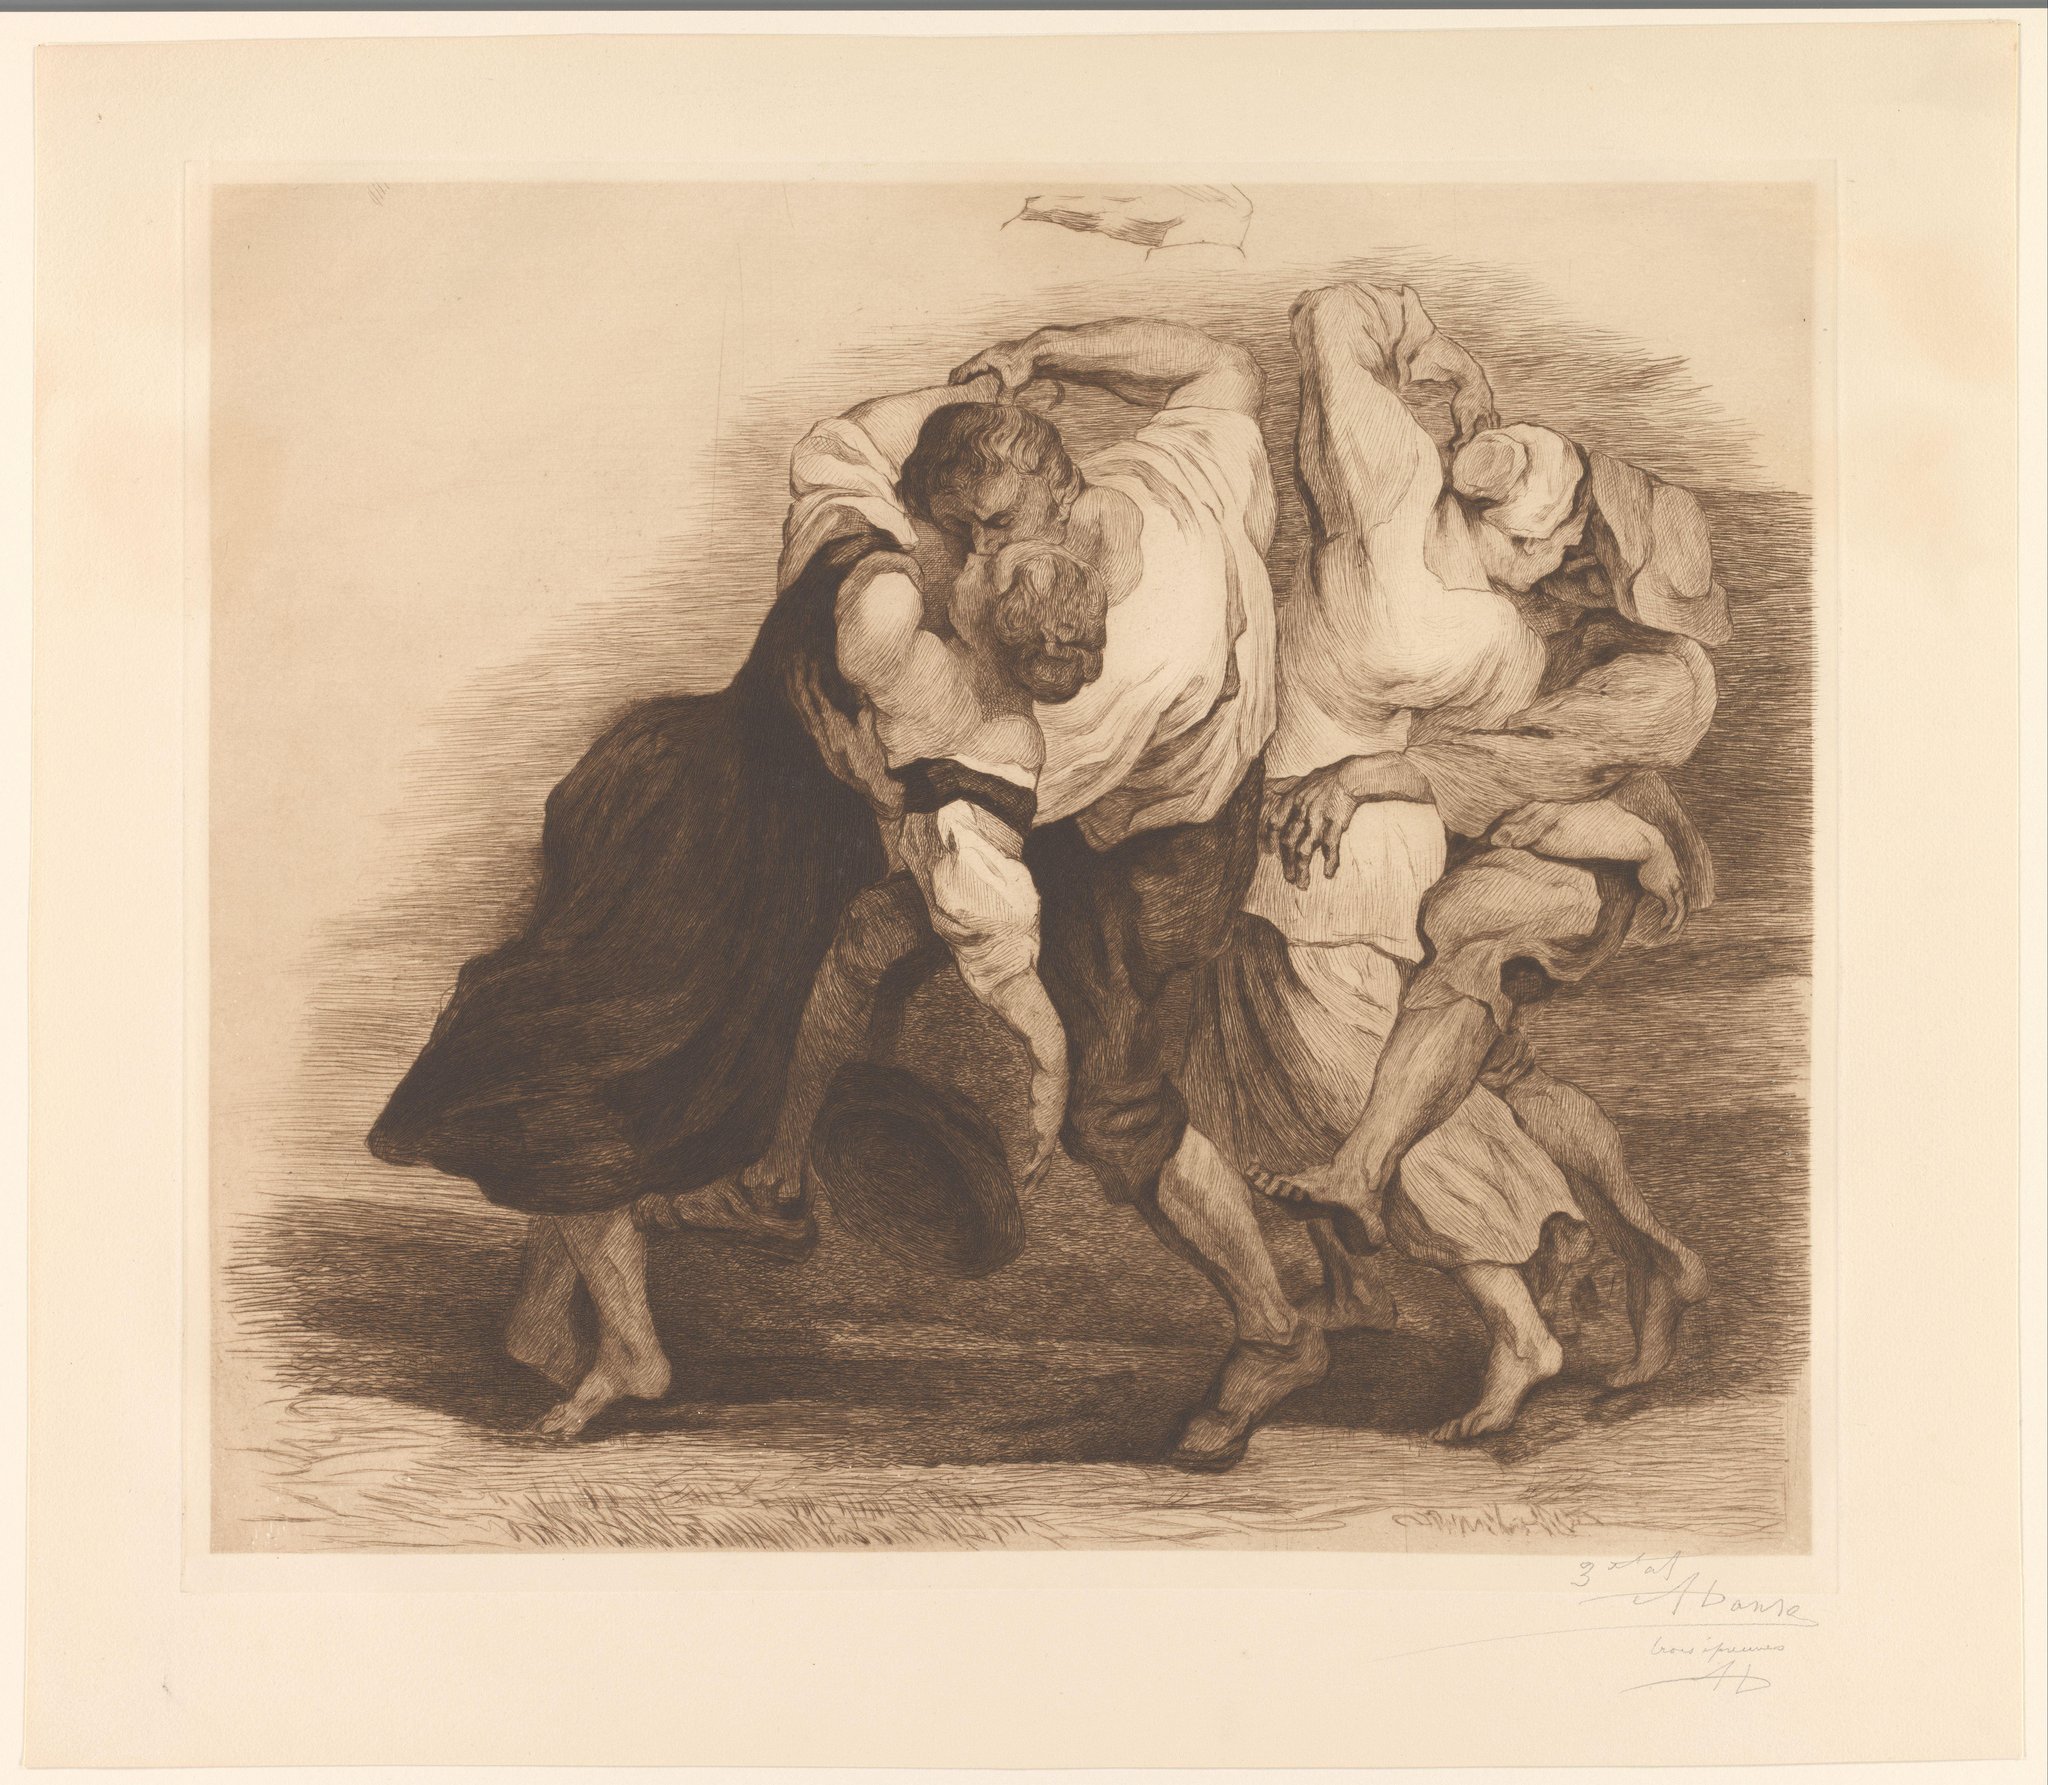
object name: print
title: Twee dansende boerenparen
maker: auguste danse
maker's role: print maker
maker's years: 1829-1929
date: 1897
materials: paper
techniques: drypoint, etching, intaglio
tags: folk dancing (men and women together)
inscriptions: annotation: ‘3 etat; trois épreuves’, collector's mark: Lugt 2228